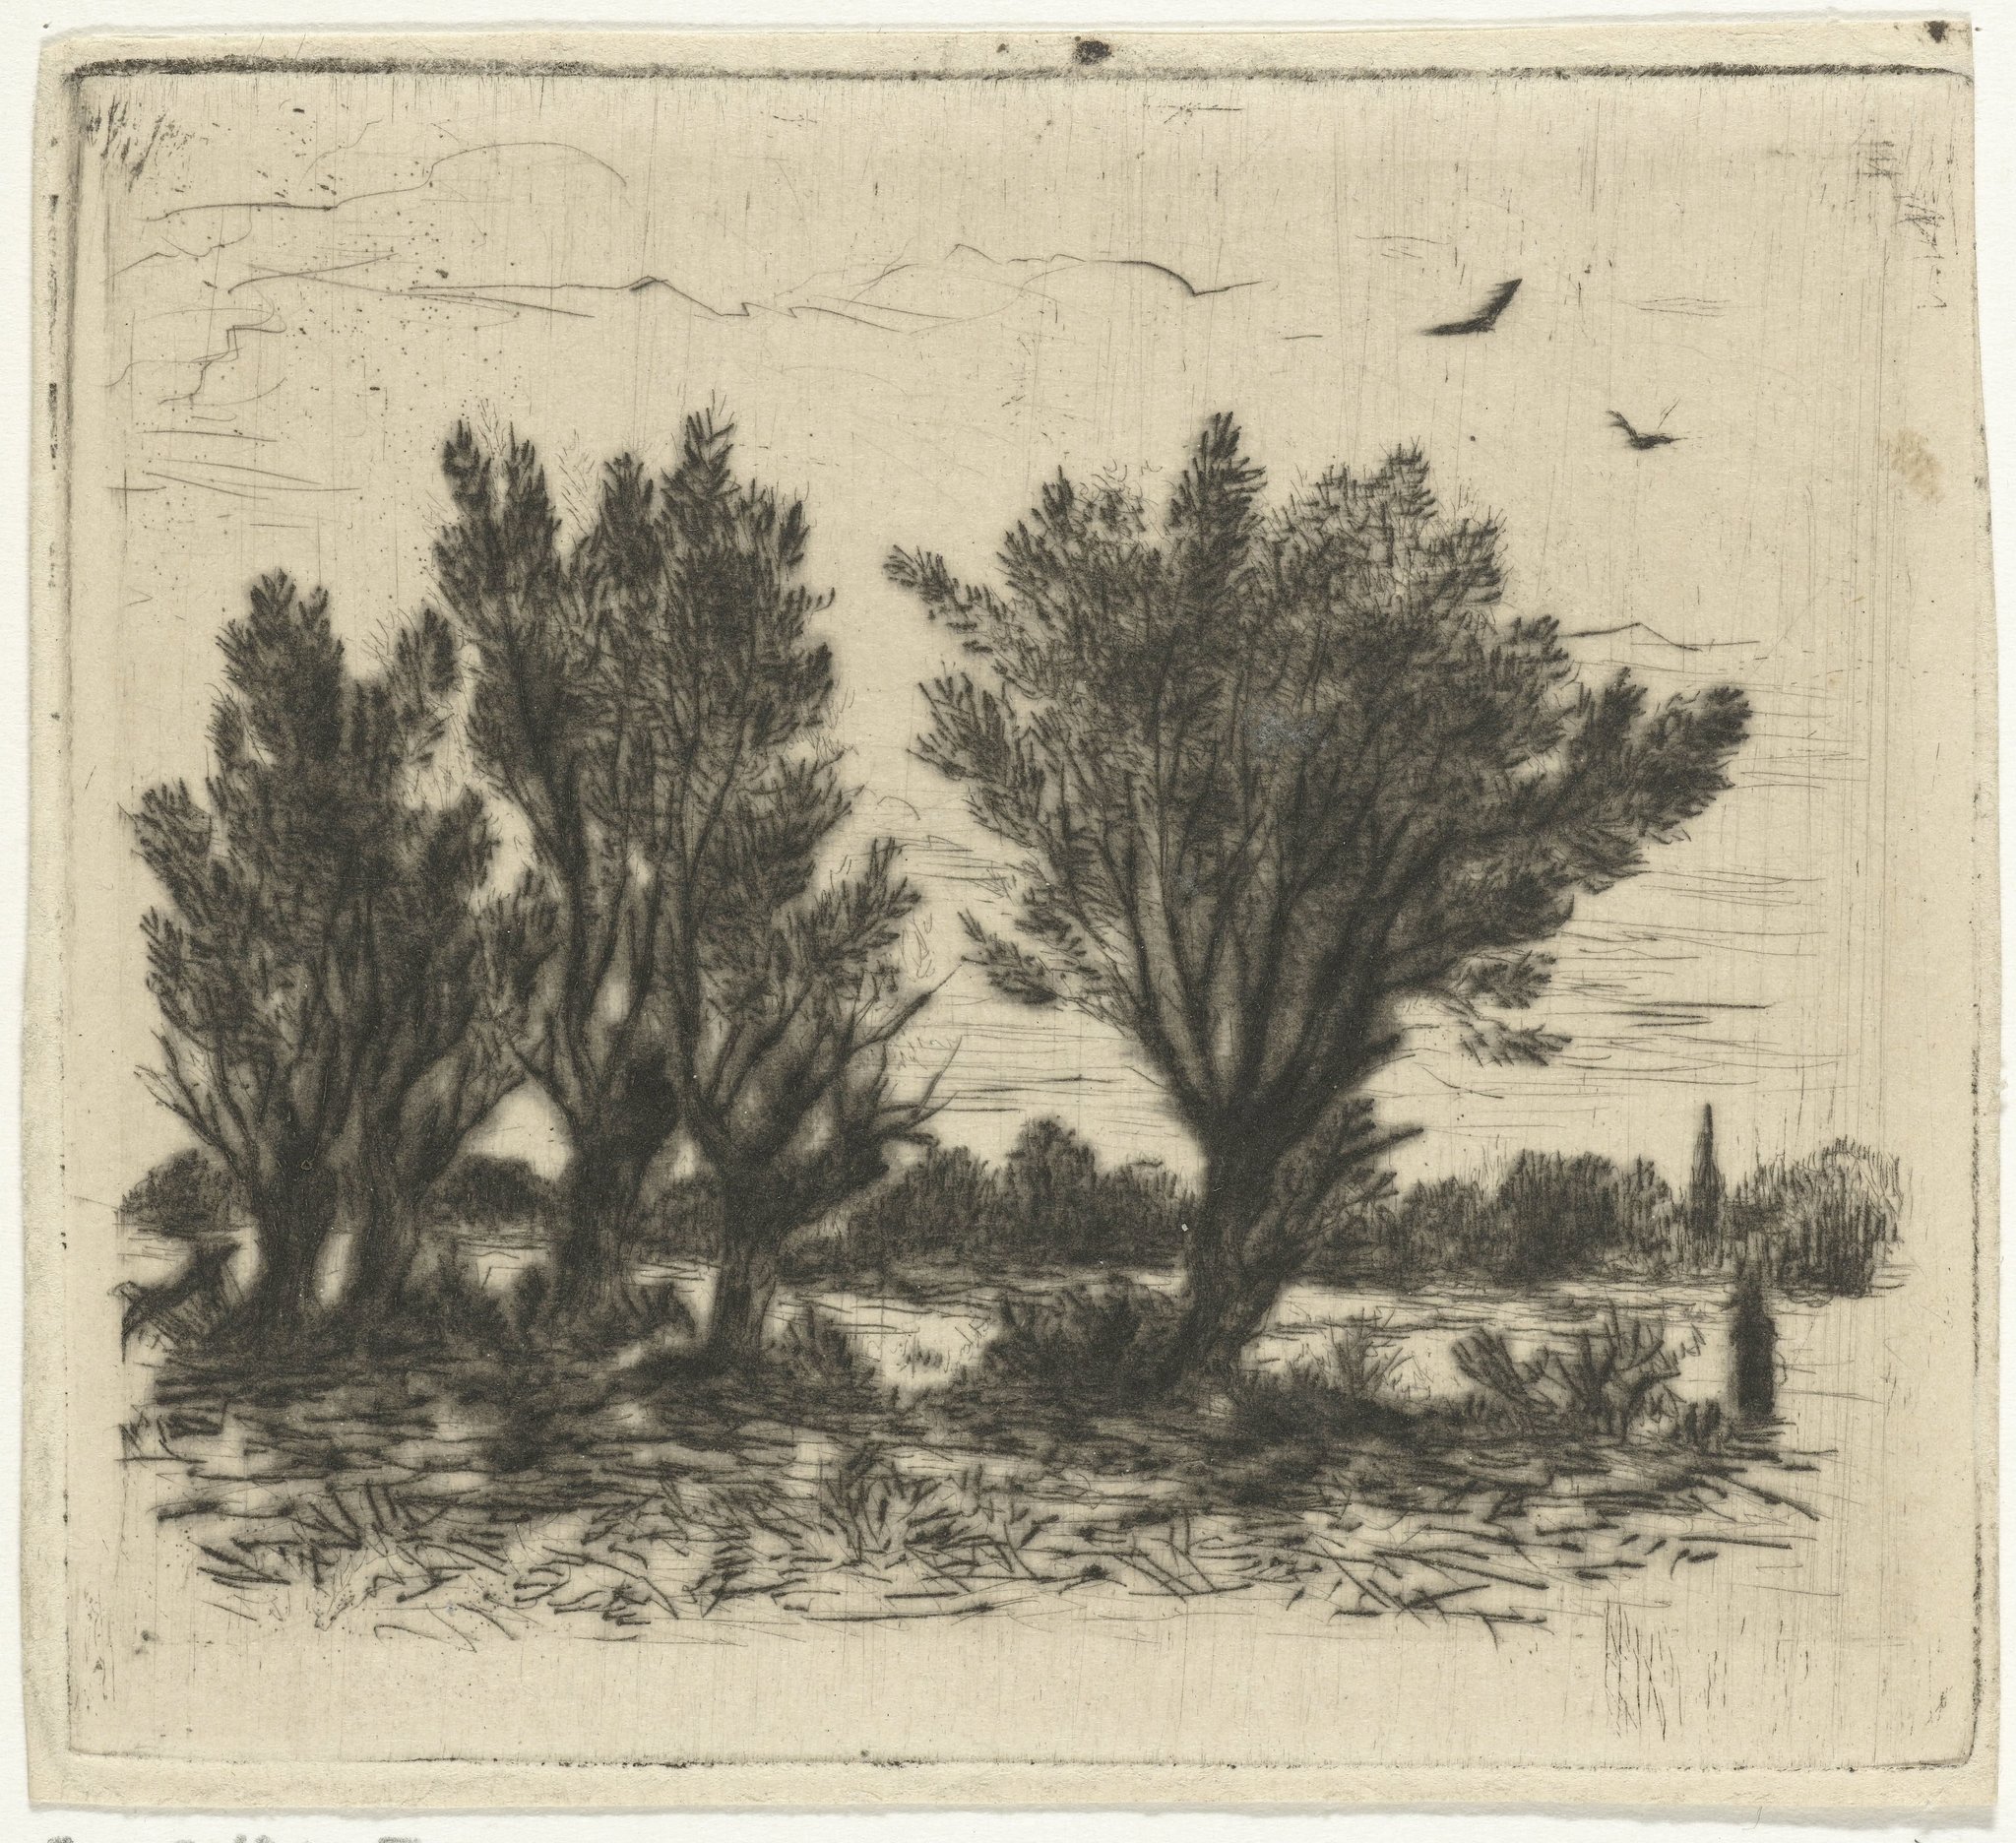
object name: print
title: Wilgenrij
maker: johan frederik croockewit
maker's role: print maker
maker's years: 1832-1898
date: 1842-1898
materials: paper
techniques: drypoint, etching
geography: amsterdam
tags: meadow, pasture, trees: willow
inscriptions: collector's mark: Lugt 2228